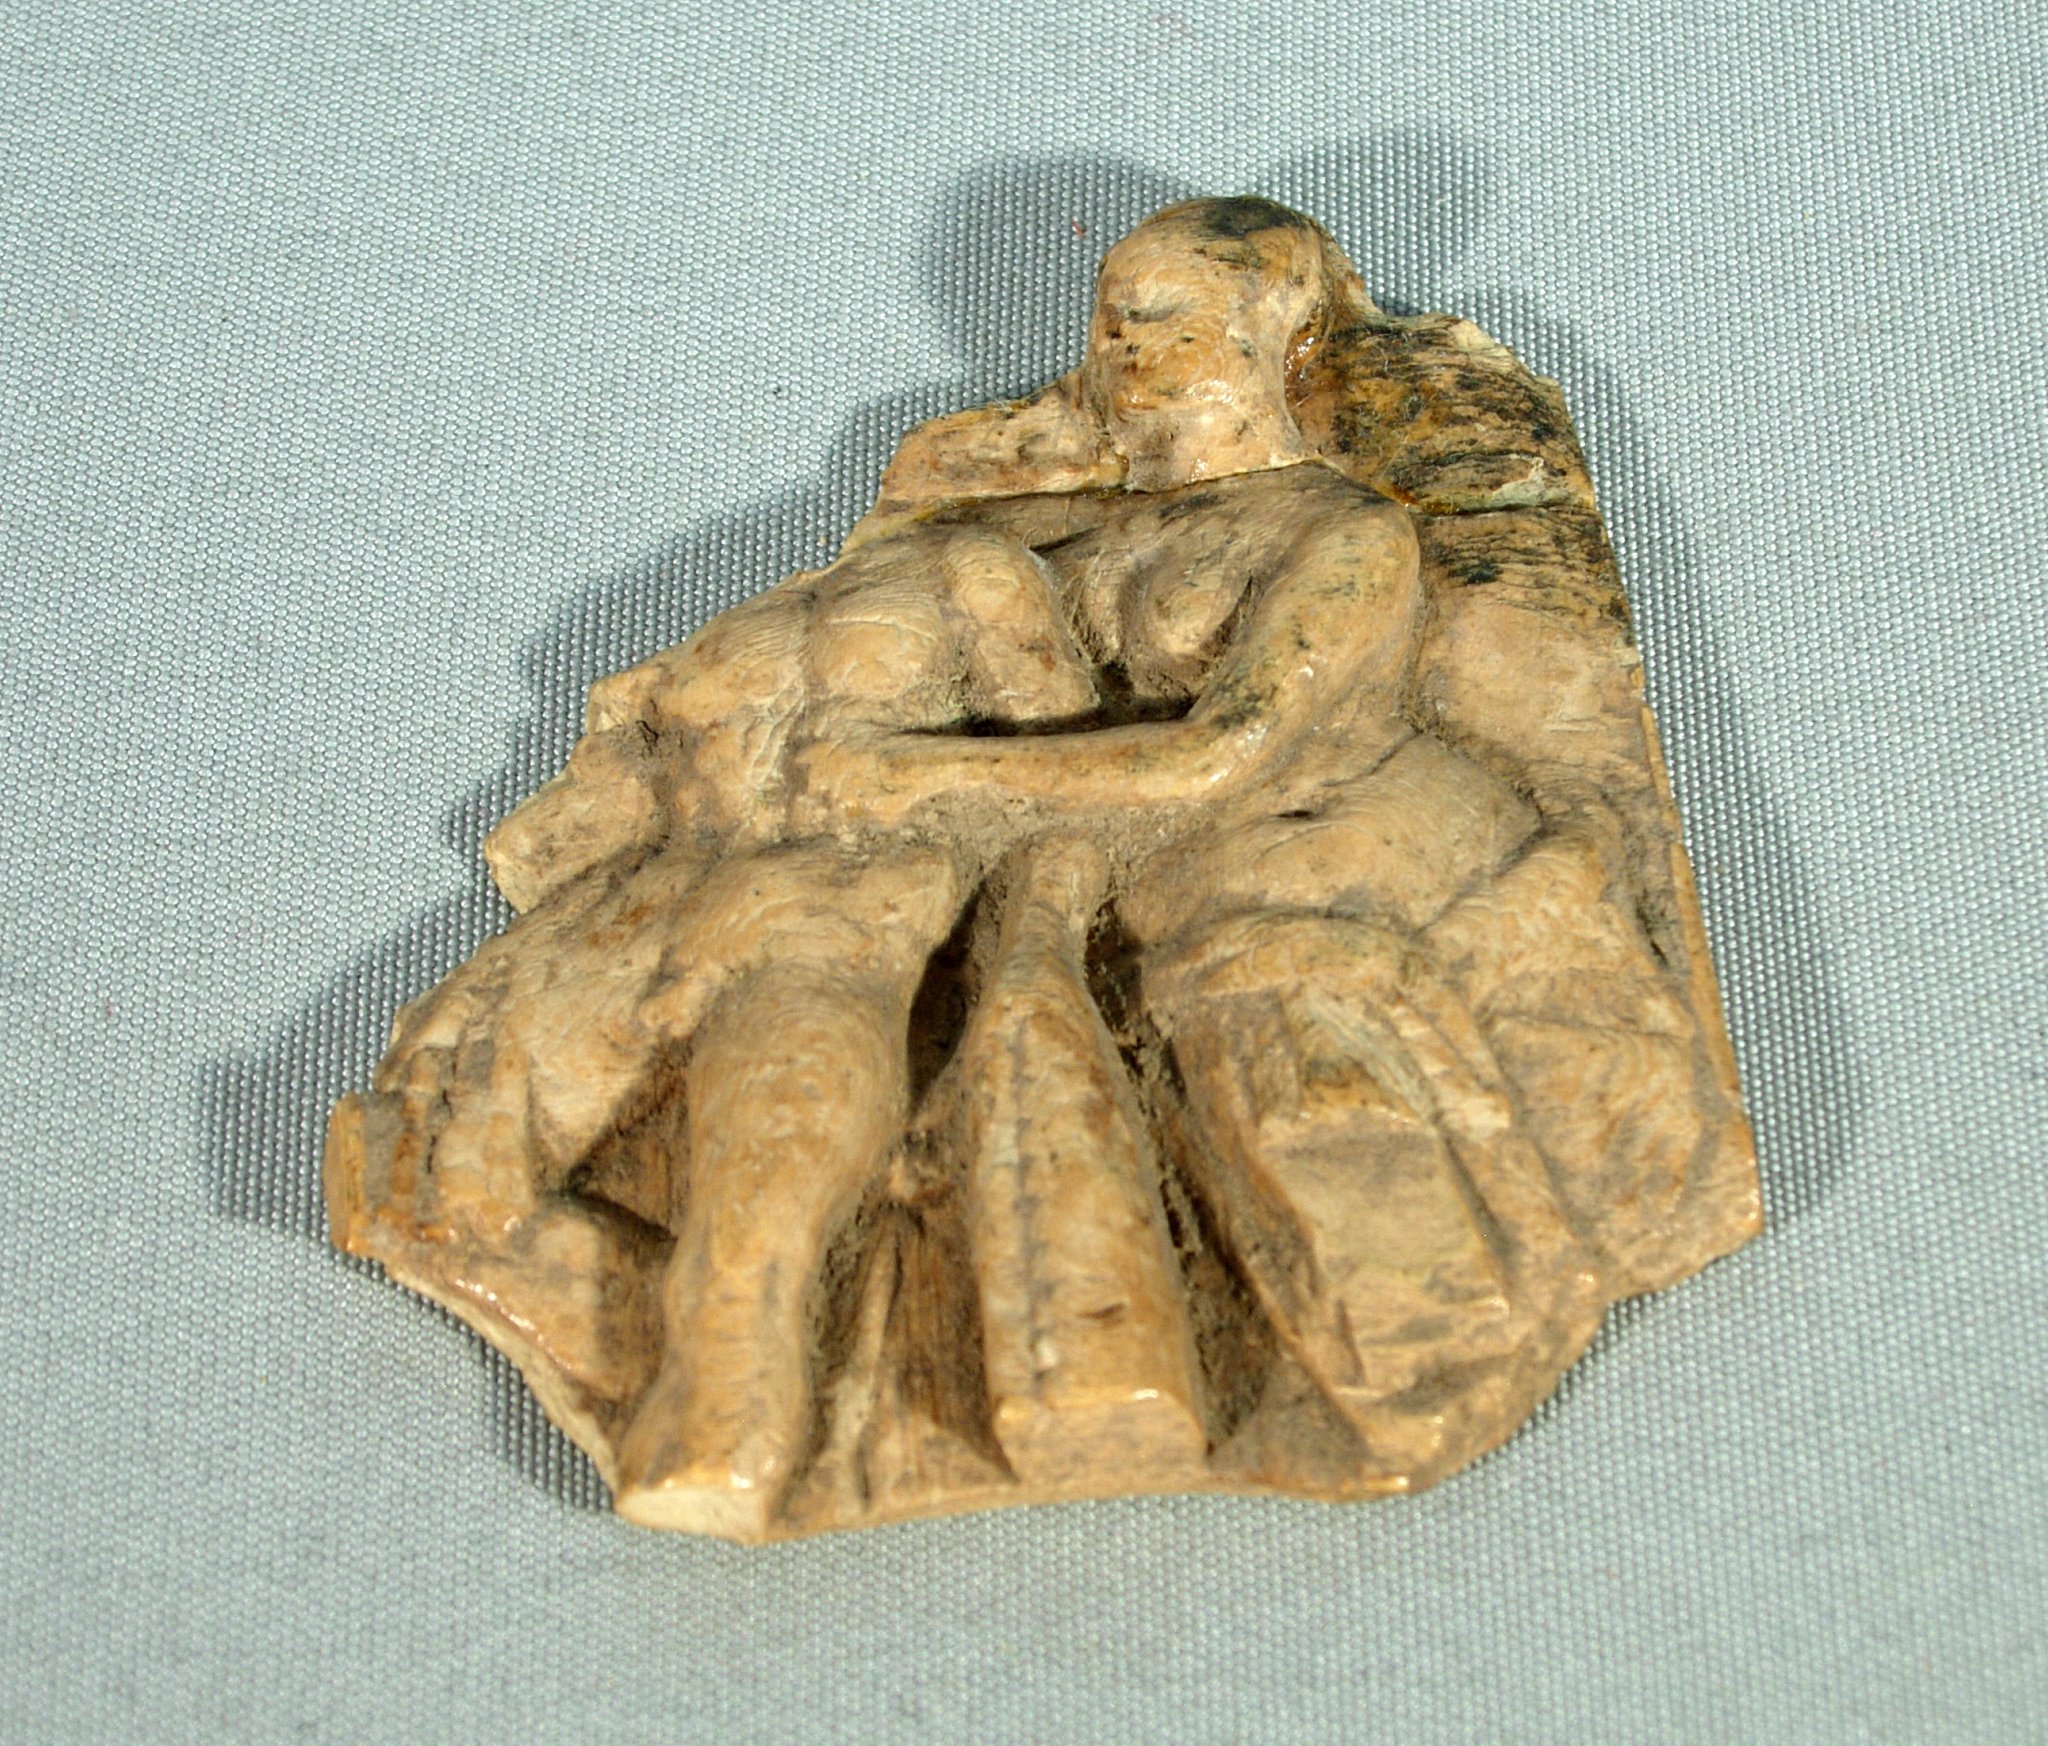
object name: fragment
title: Panel with Lovers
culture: byzantine or roman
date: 301-600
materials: bone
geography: egypt